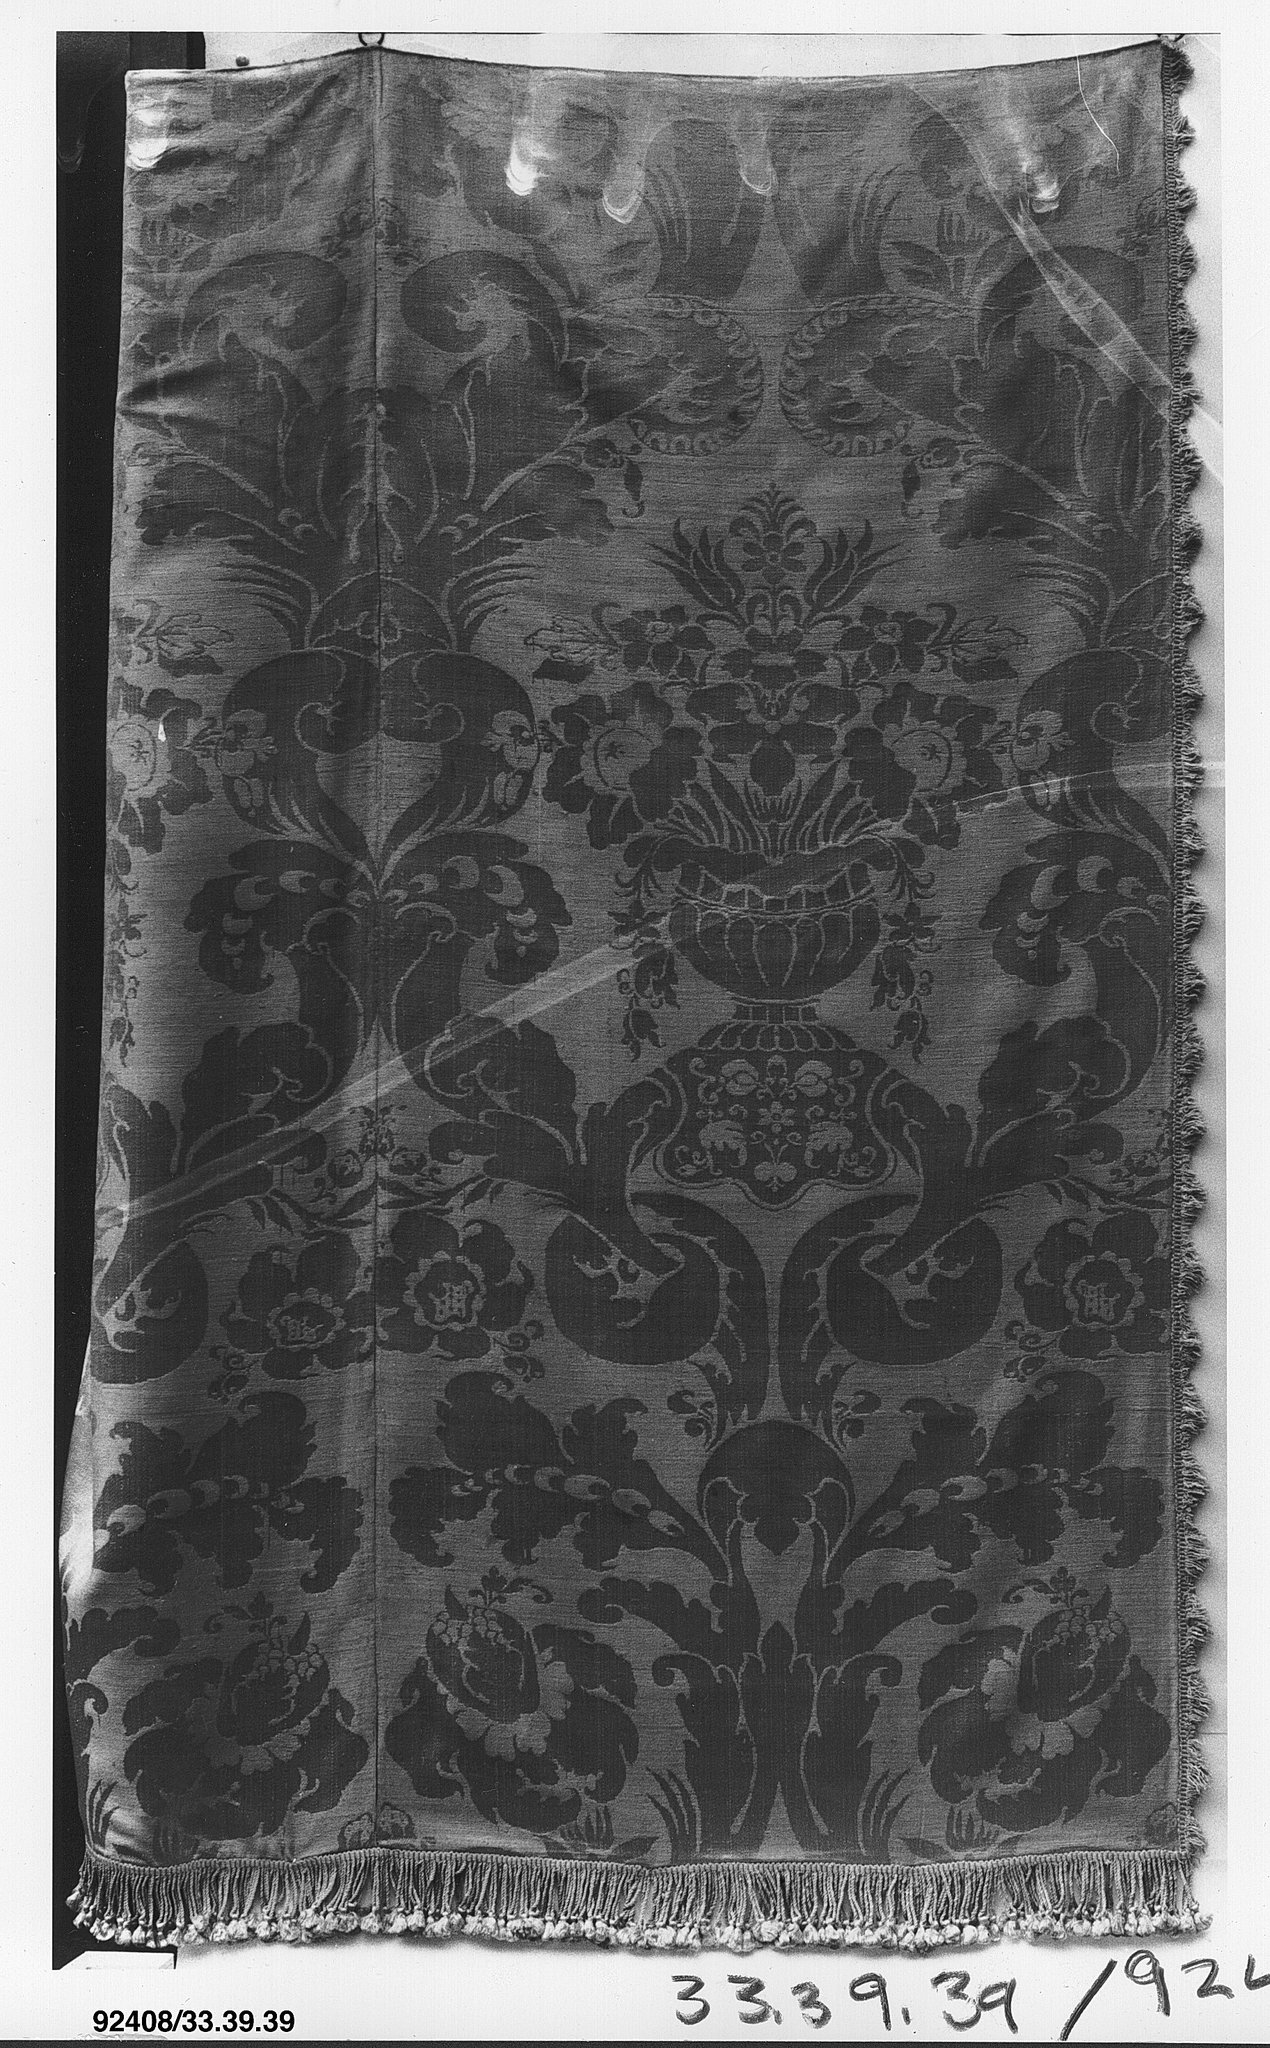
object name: piece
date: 1710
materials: silk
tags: flowers,leaves